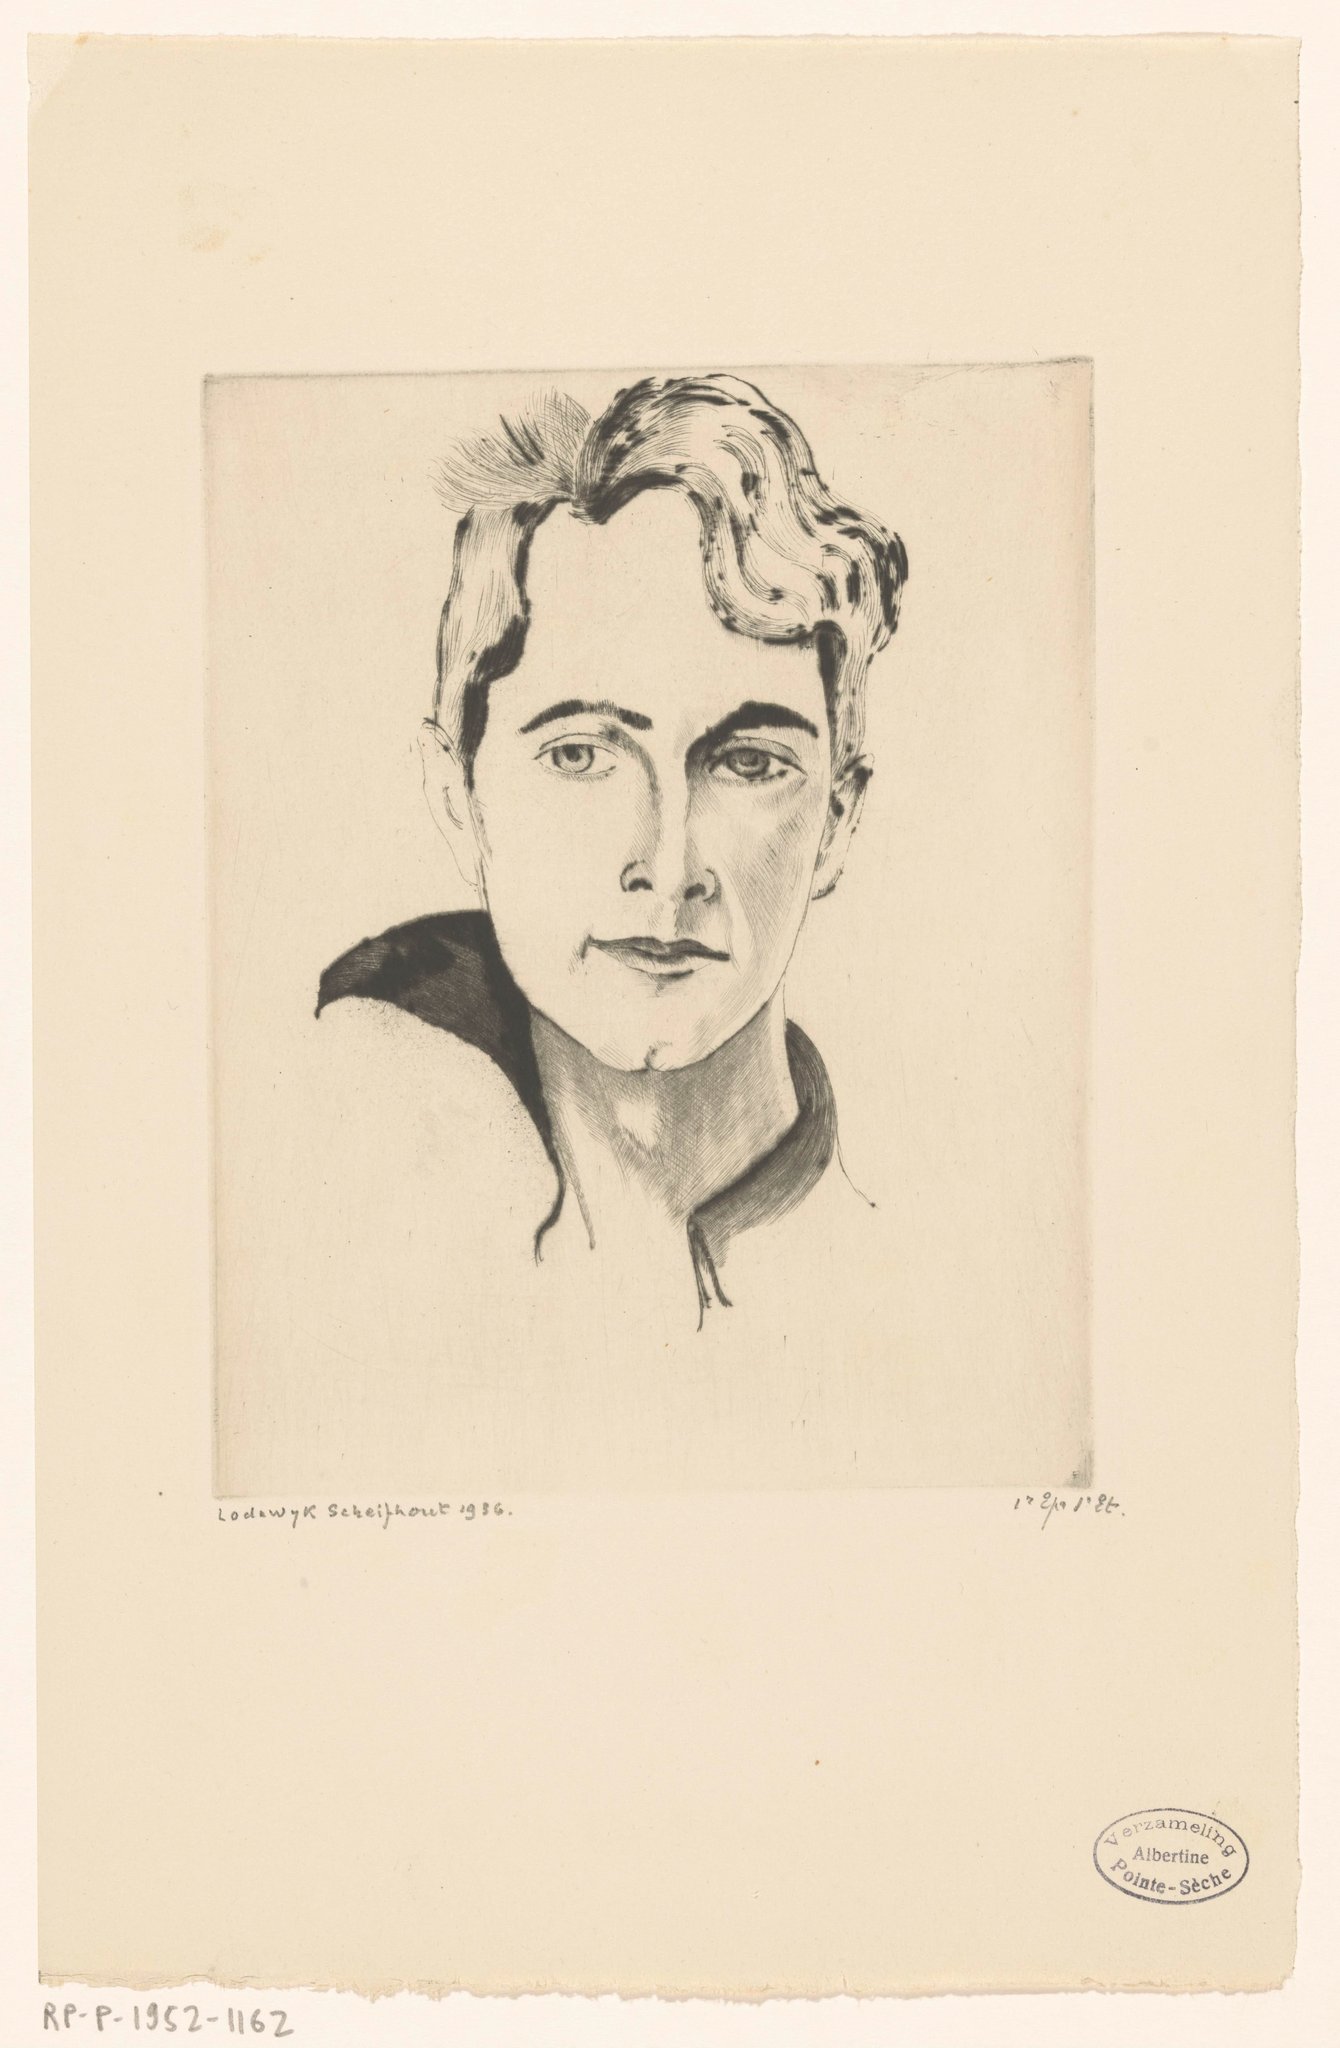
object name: print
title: Portret van Patrick Bakker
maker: lodewijk schelfhout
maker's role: draughtsman, print maker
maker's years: 1881-1943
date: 1936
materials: paper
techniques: drypoint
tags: painter, draughtsman, portrait, self-portrait of artist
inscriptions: collector's mark: Lugt 2228, collector's mark: Lugt 5i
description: Een portret van kunstenaar Patrick Bakker, die een hemd draagt met opstaande kraag.